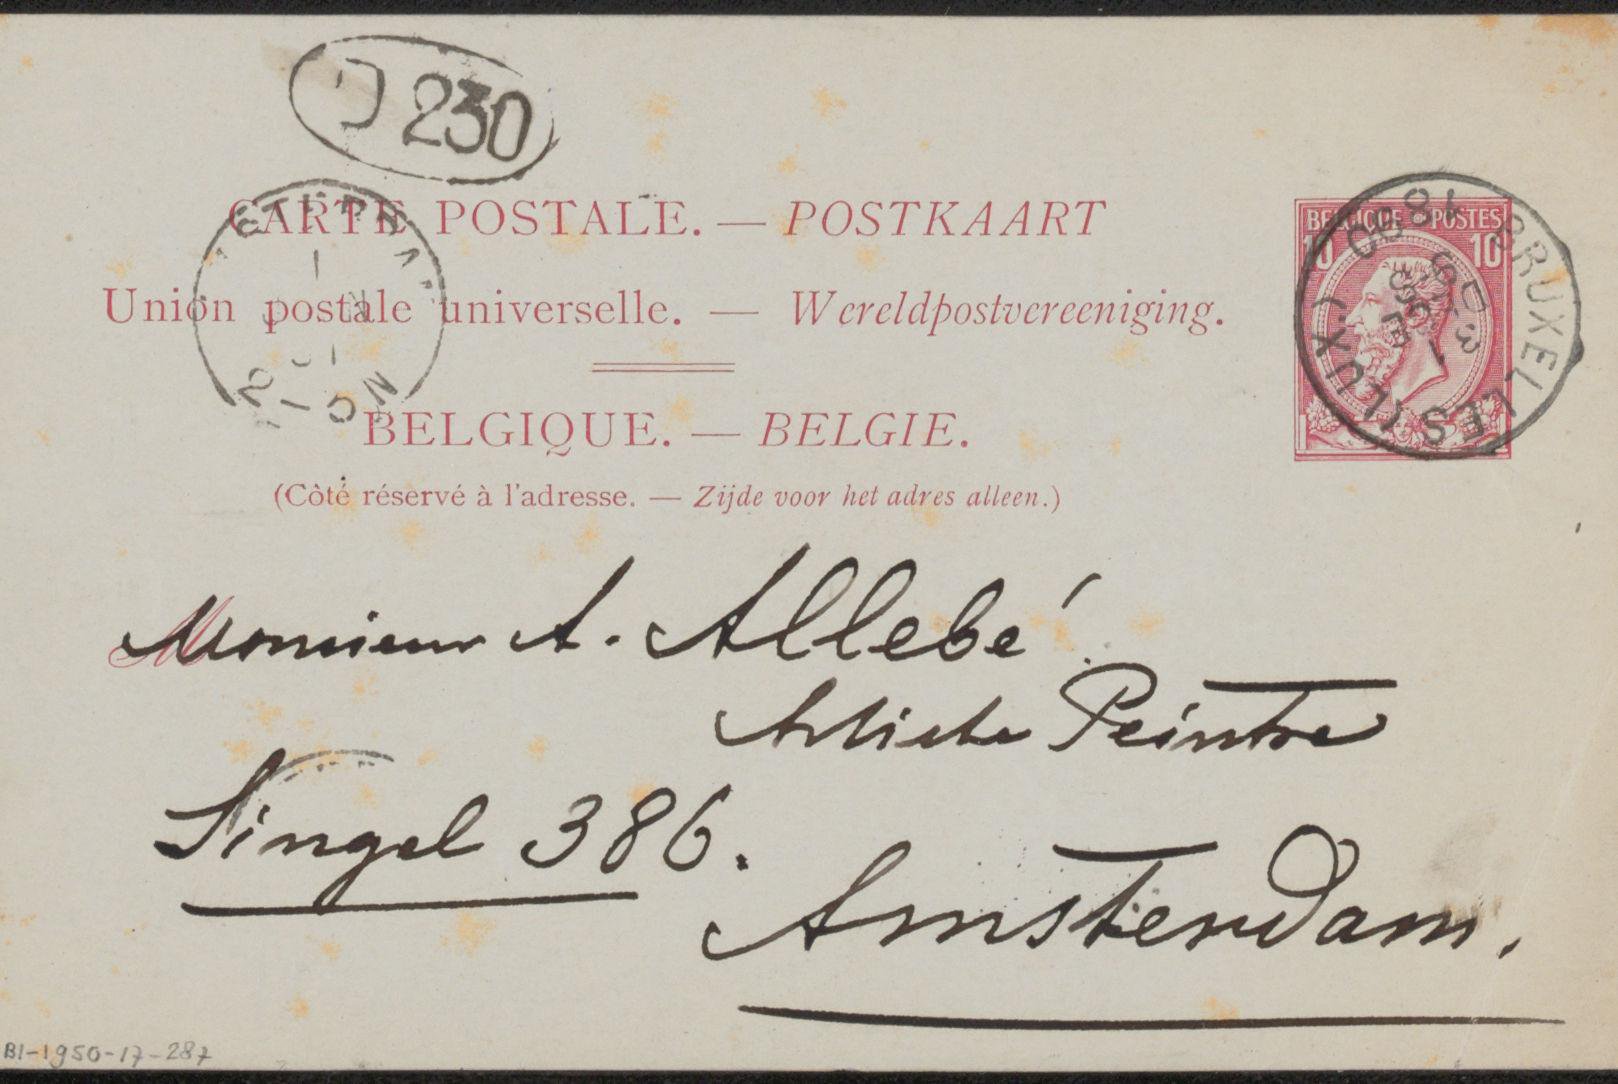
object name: postcard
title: Briefkaart aan August Allebé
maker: johannes hubertus leonardus de haas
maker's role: draughtsman, painter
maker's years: 1832-1908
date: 1890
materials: cardboard, ink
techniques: pen, writing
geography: brussels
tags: amsterdam, print maker, draughtsman, august allebé